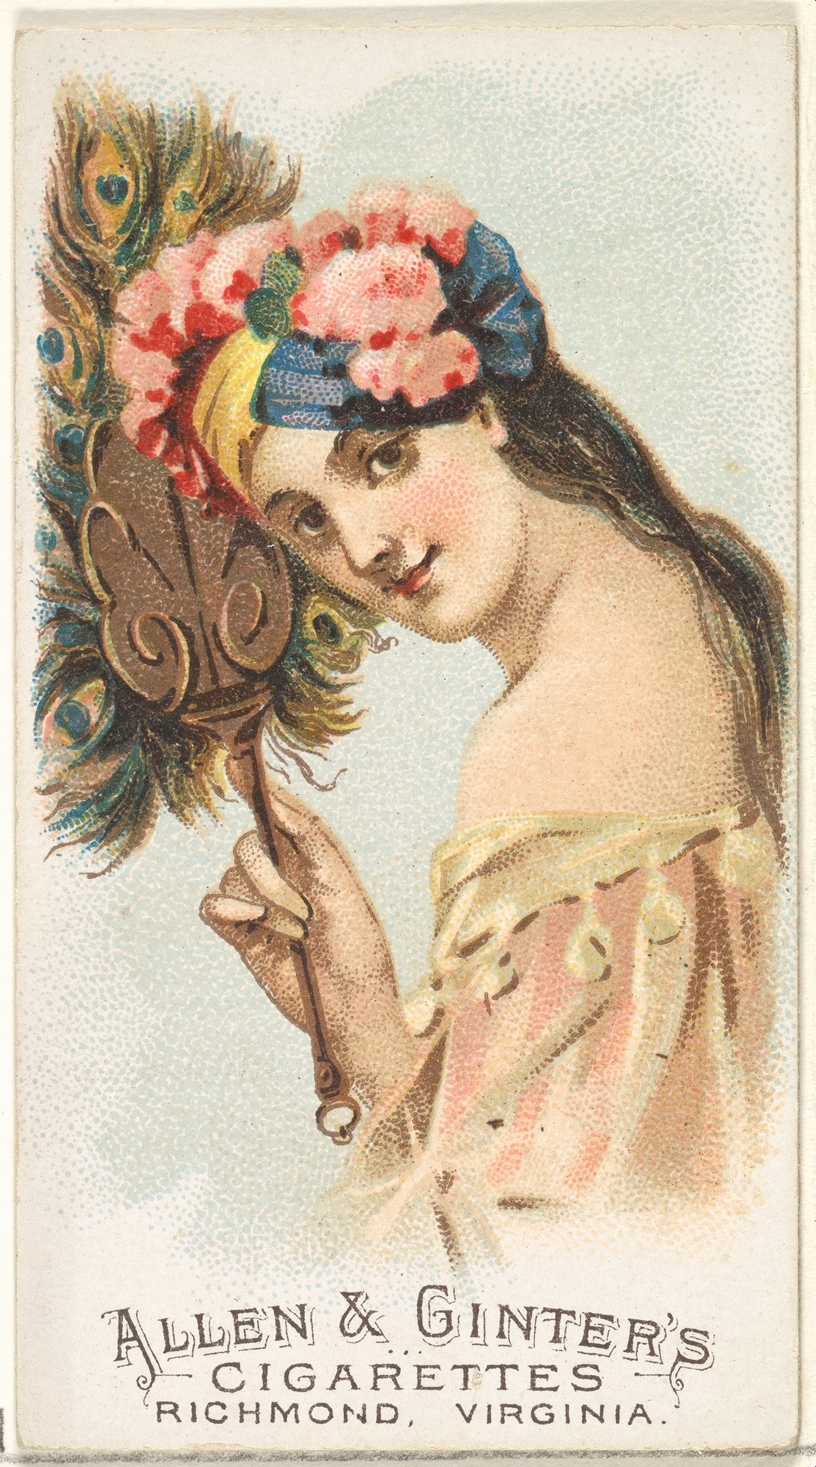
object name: print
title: Plate 12, from the Fans of the Period series (N7) for Allen & Ginter Cigarettes Brands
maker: allen & ginter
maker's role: publisher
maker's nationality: american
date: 1889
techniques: color lithograph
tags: fans,women